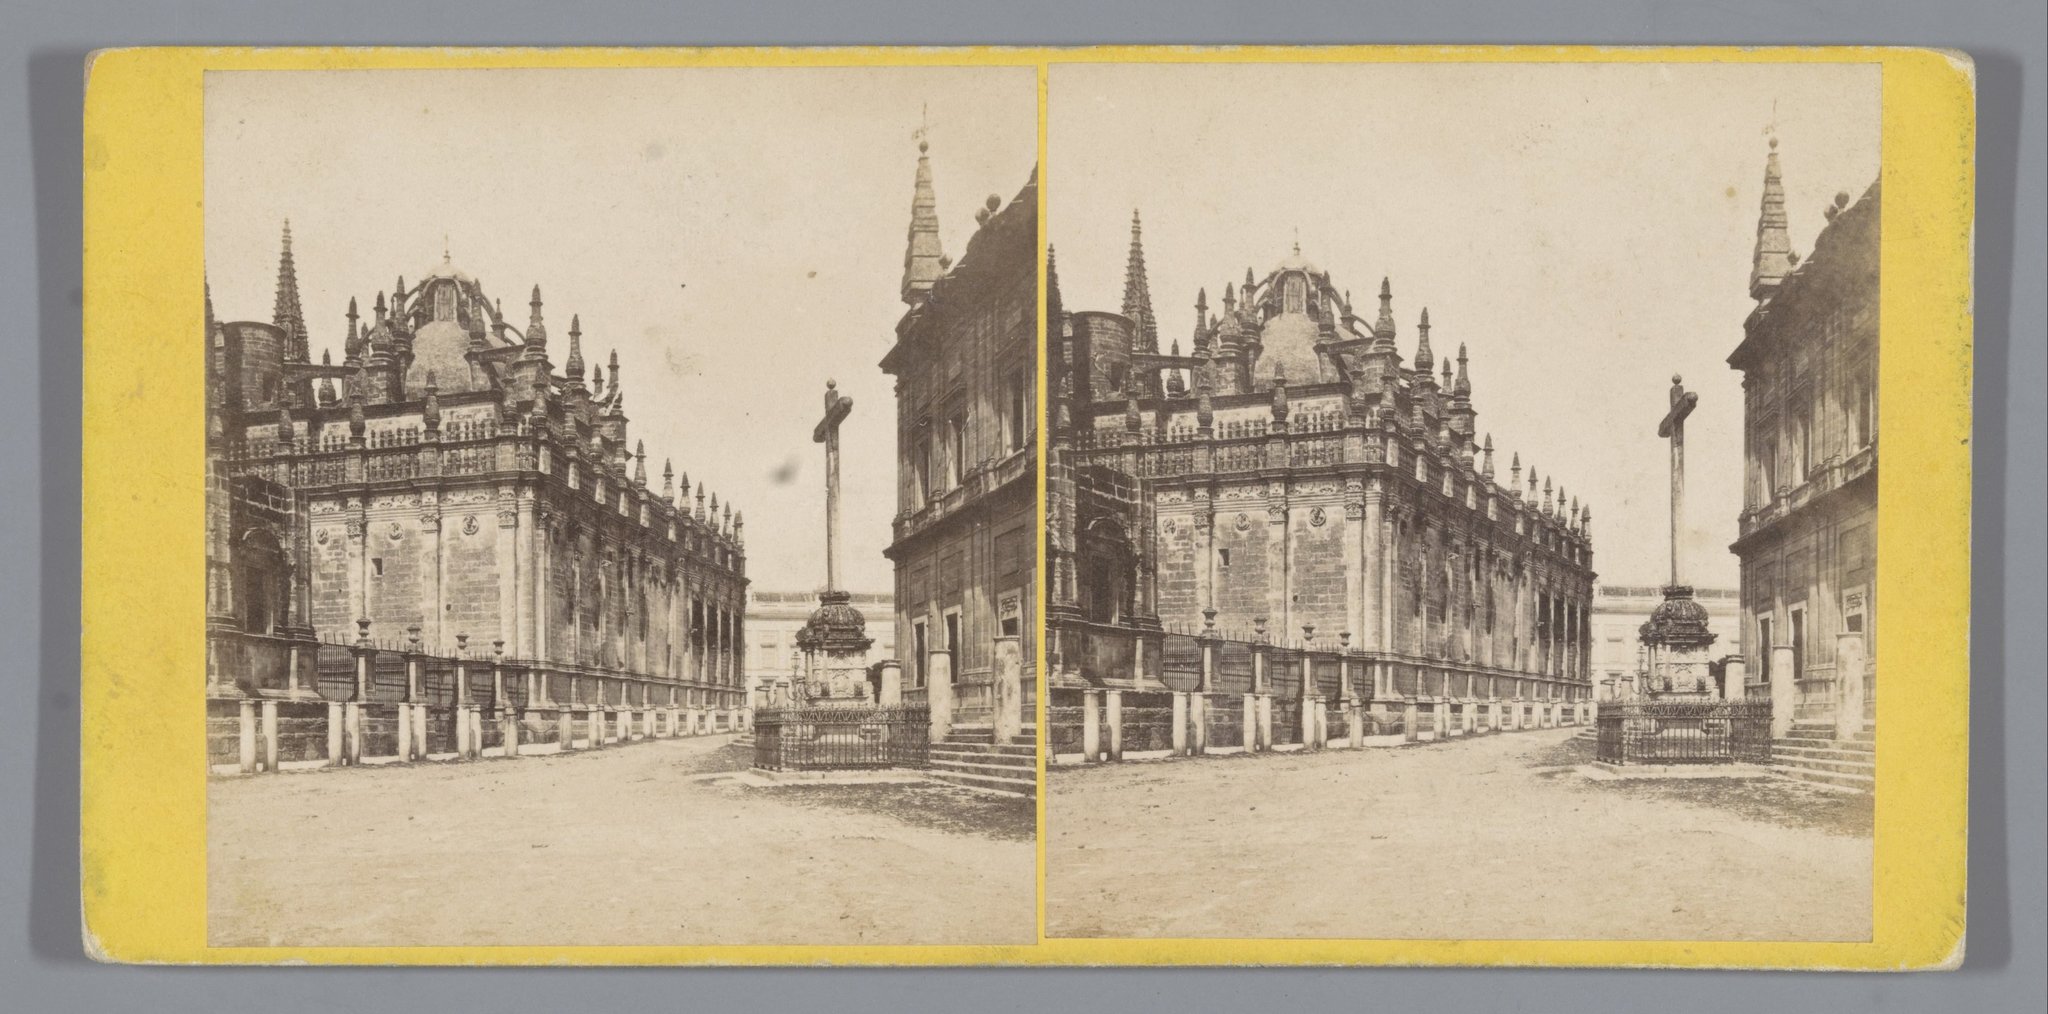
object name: stereograph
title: SEVILLE- Mosque part of the Cathedral.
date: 1850-1880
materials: cardboard, photographic support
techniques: albumen print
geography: london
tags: church (exterior), façade (of house or building)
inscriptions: number: ‘No. 319.’, name: ‘Frank M. Good's Spain’